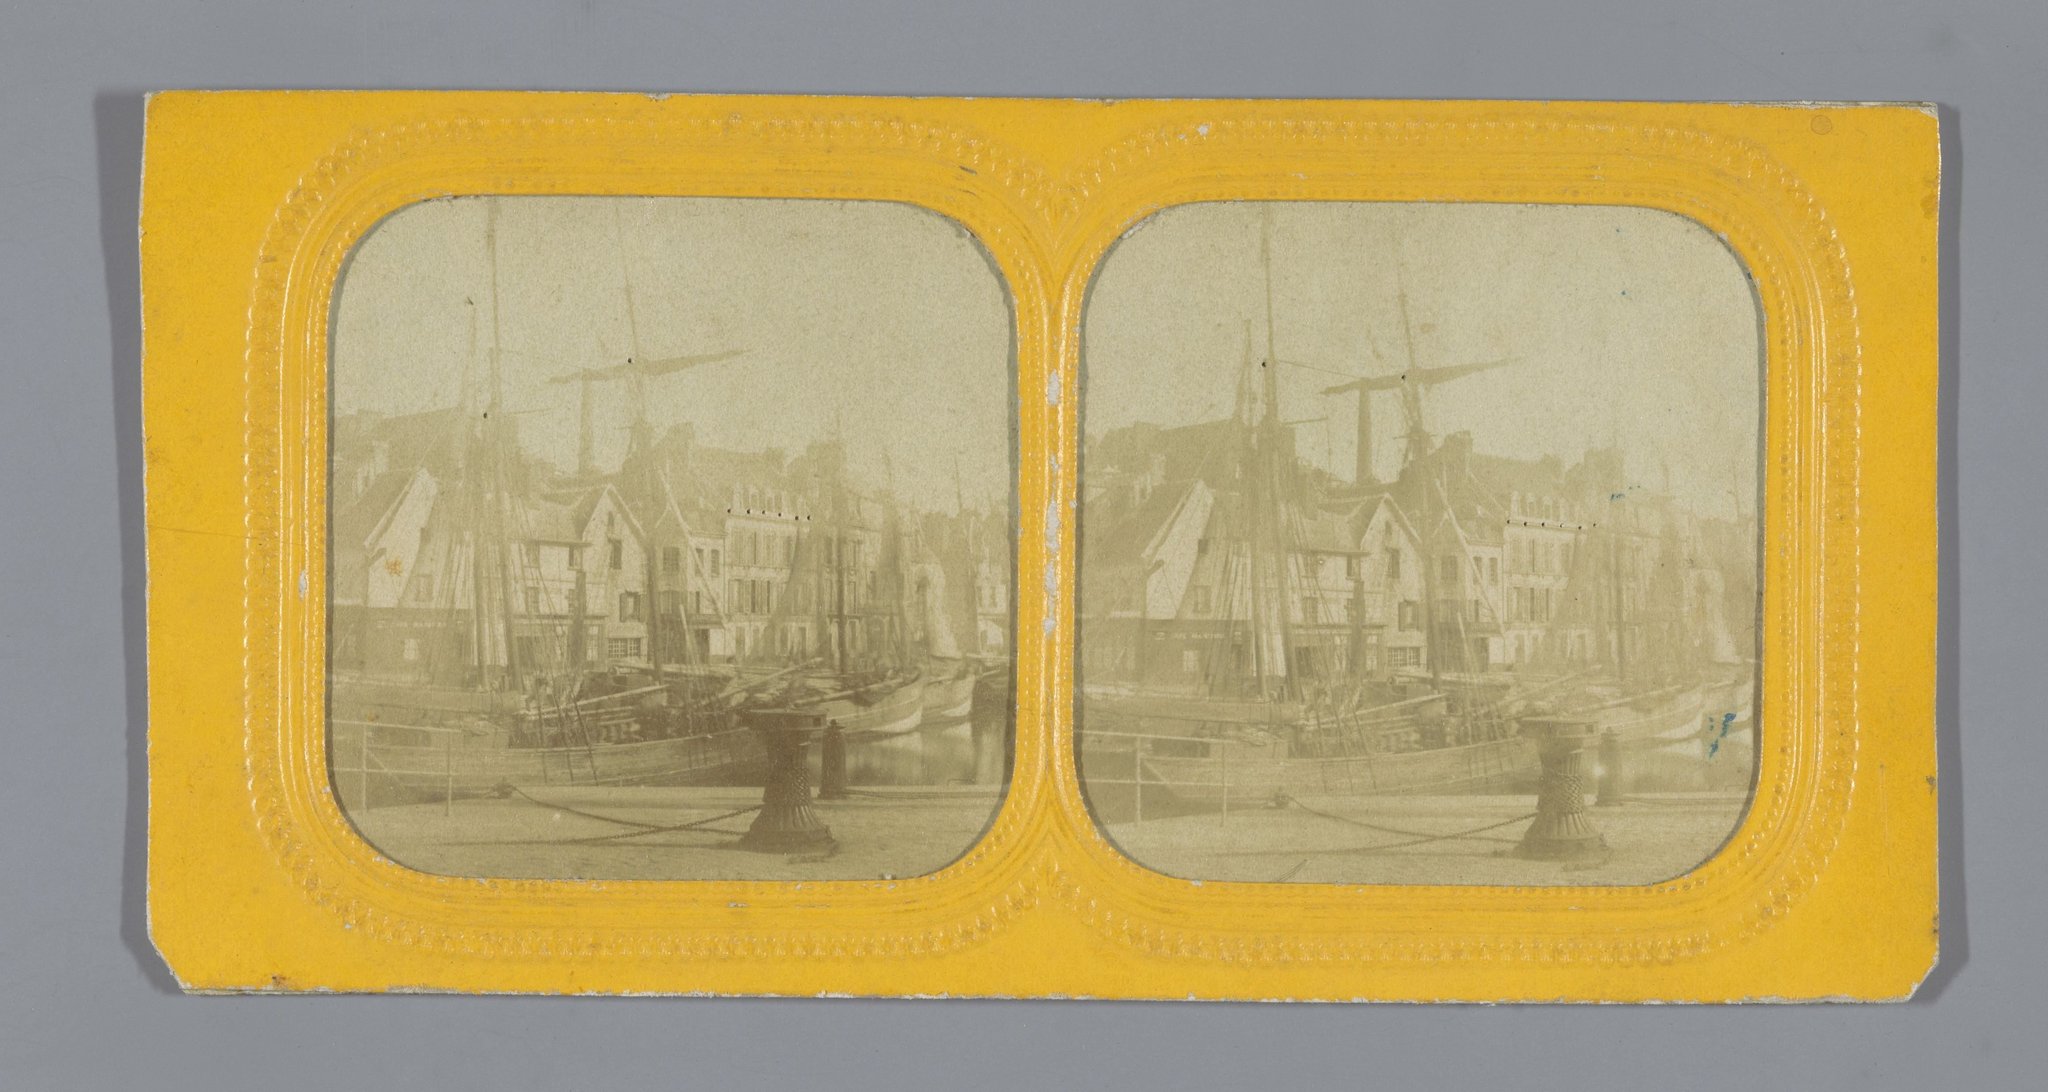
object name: tissue stereograph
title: Dieppe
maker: Anonymous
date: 1855-1875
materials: cardboard, paper, photographic support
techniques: albumen print, hand coloring, perforating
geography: dieppe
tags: harbour, ships (in general)